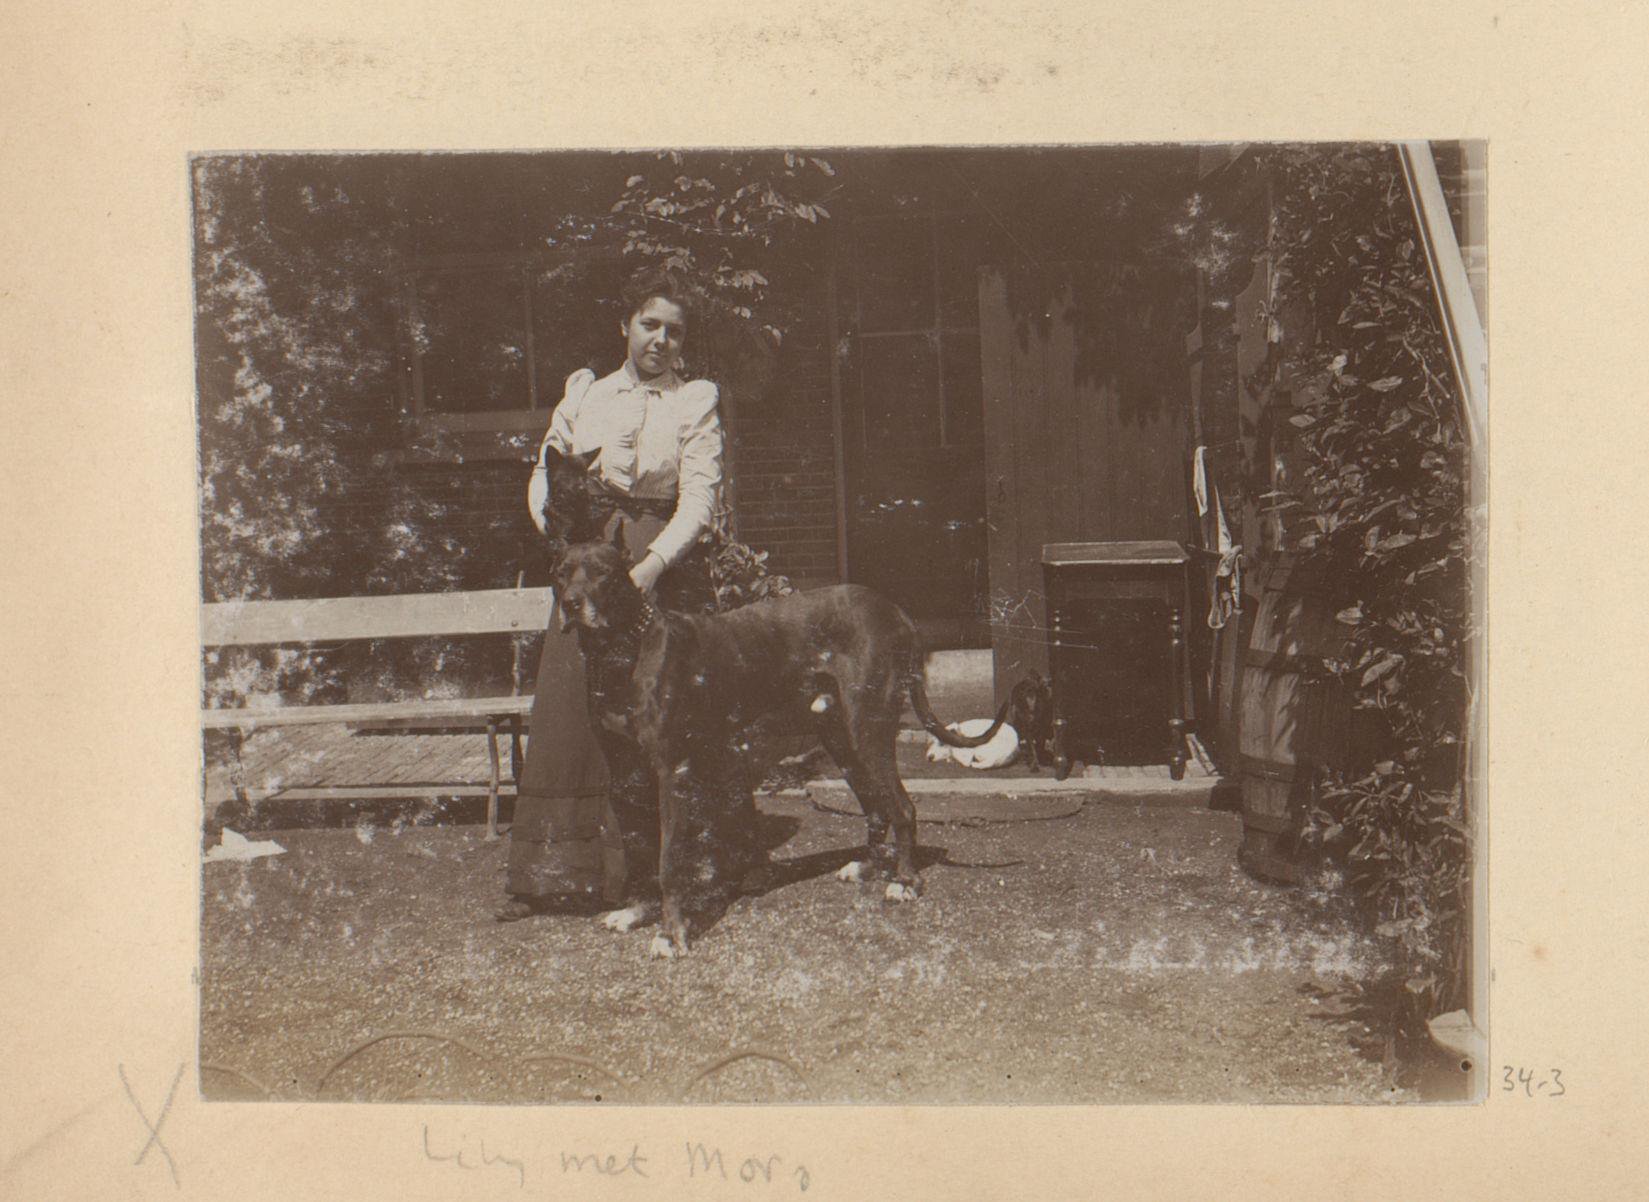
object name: photograph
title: Lily met Moro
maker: hendrik herman van den berg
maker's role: amateurfotograaf, jurist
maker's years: 1875-1944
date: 1890-1894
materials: paper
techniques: collodion silver print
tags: historical persons - bb - woman, dog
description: Foto 3 op albumblad 34 uit album "Amsterdam 1890-1894".